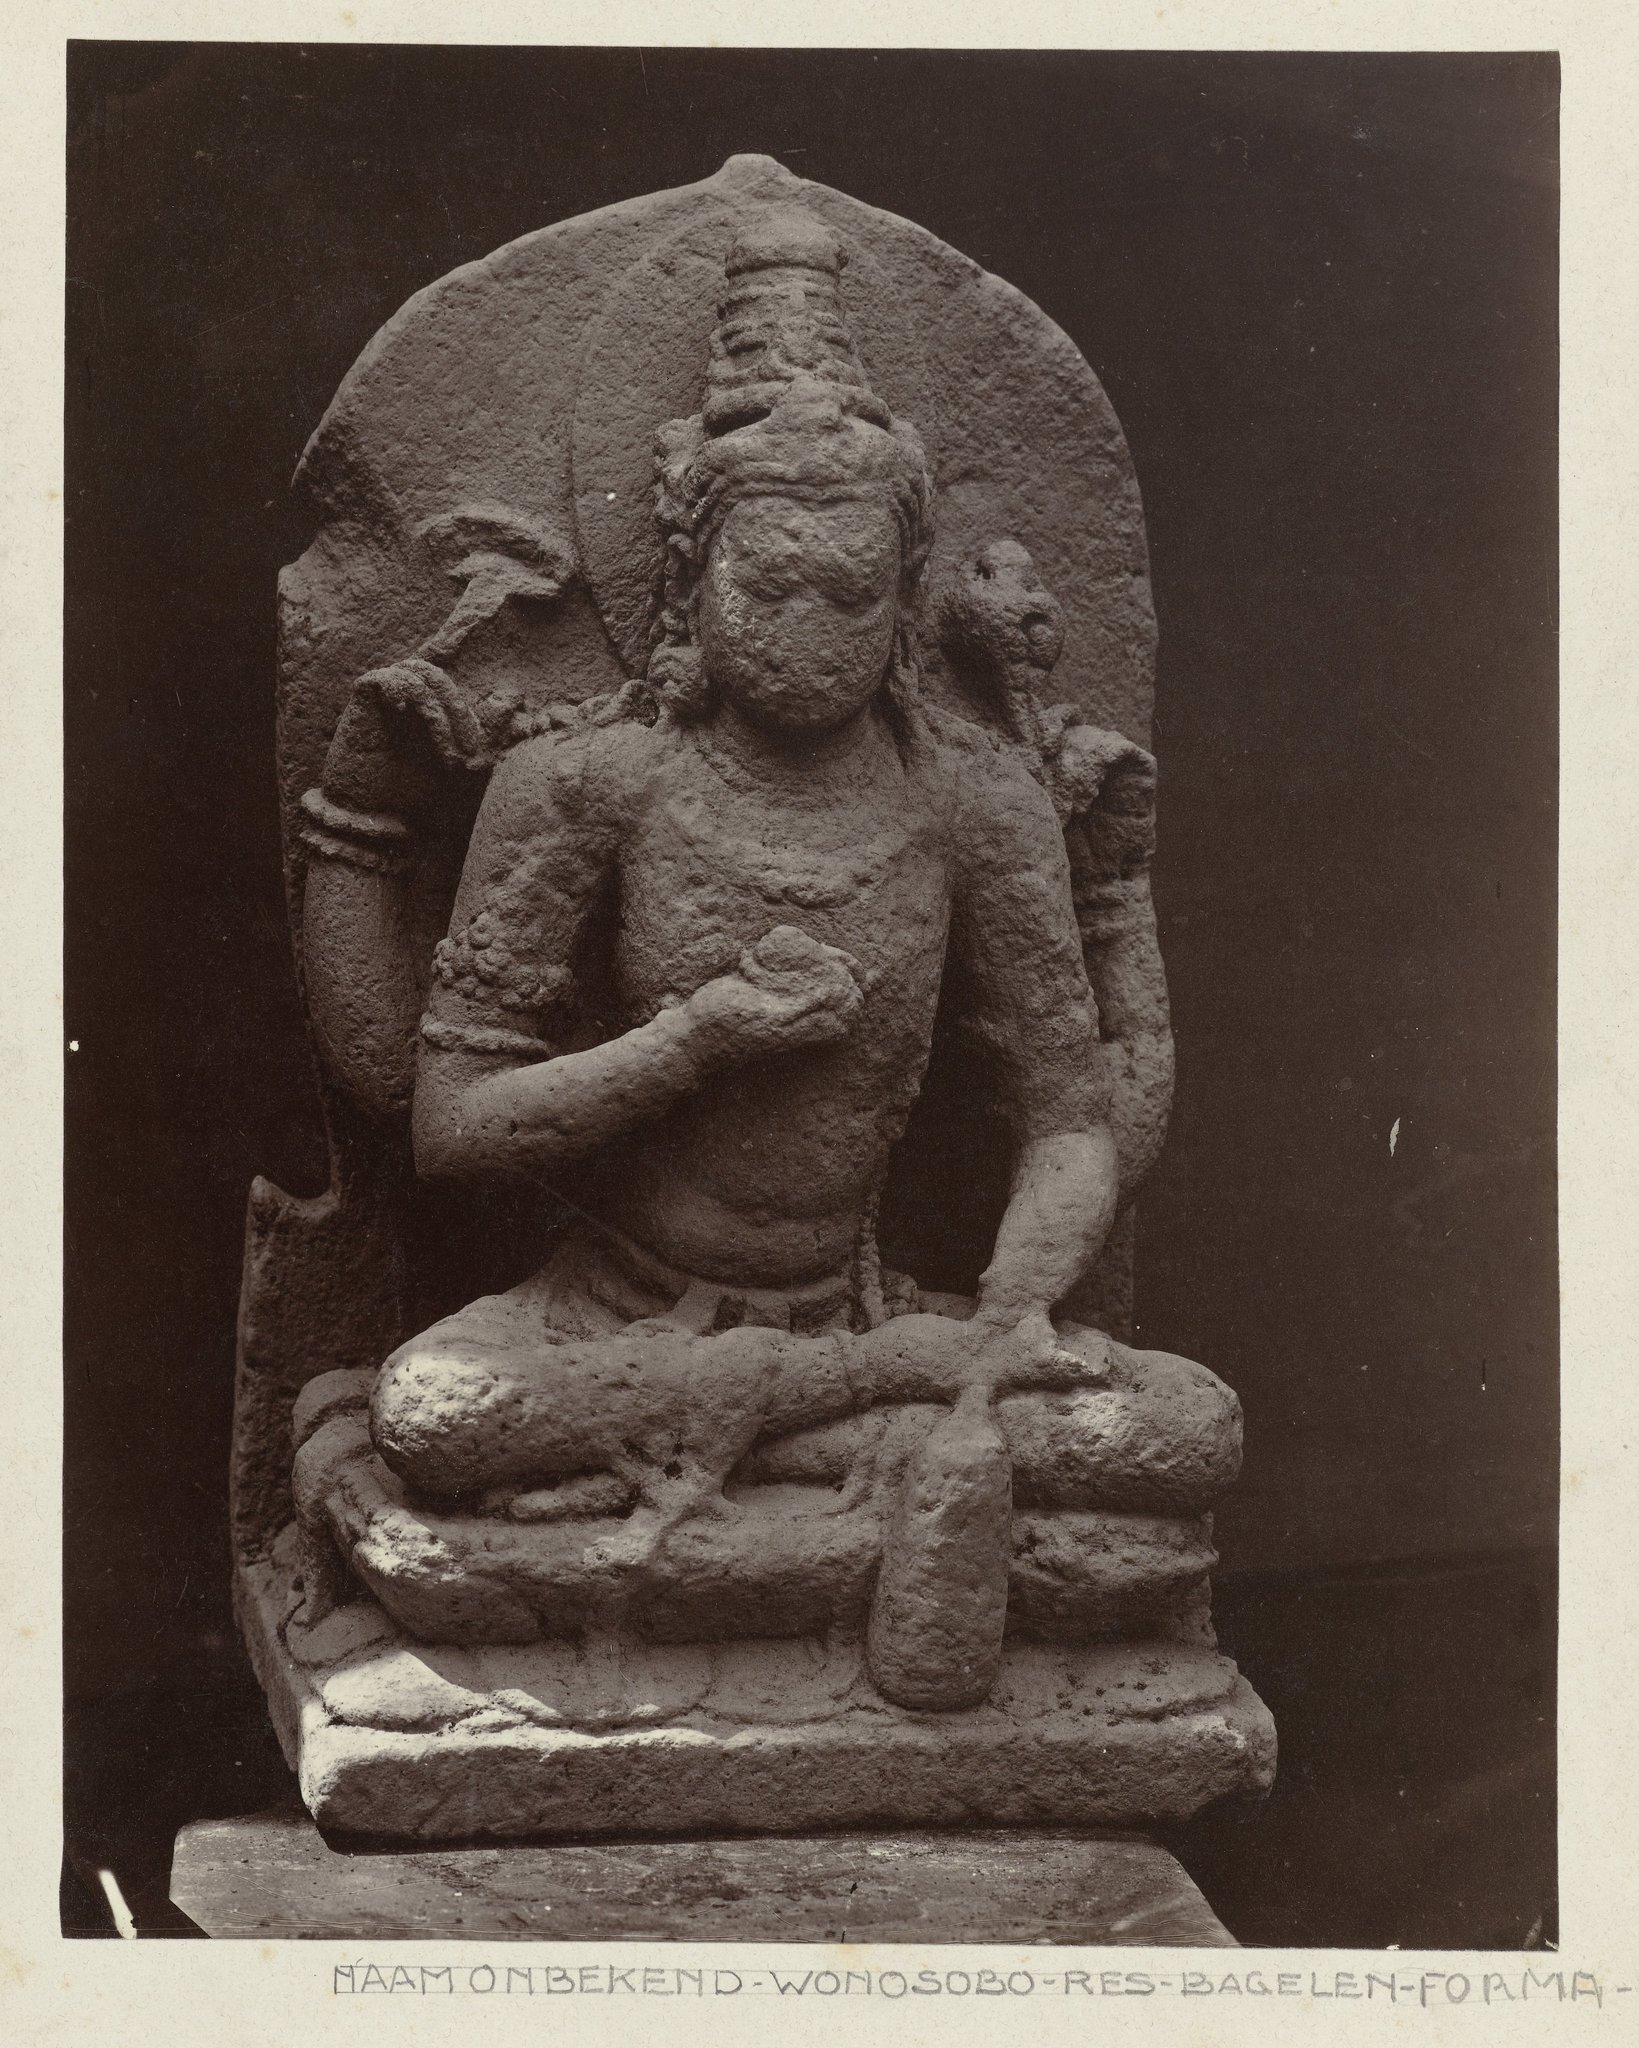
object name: photograph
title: Beeld van een zittende vierarmige Vishnu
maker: isidore kinsbergen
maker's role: fotograaf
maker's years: 1821-1905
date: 1808-1864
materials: cardboard, paper, photographic support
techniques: albumen print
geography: java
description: Four-armed Vishnu (provenance Dieng Plateau) Wonosobo, Wonosobo district, Central Java province, 10th-11th century